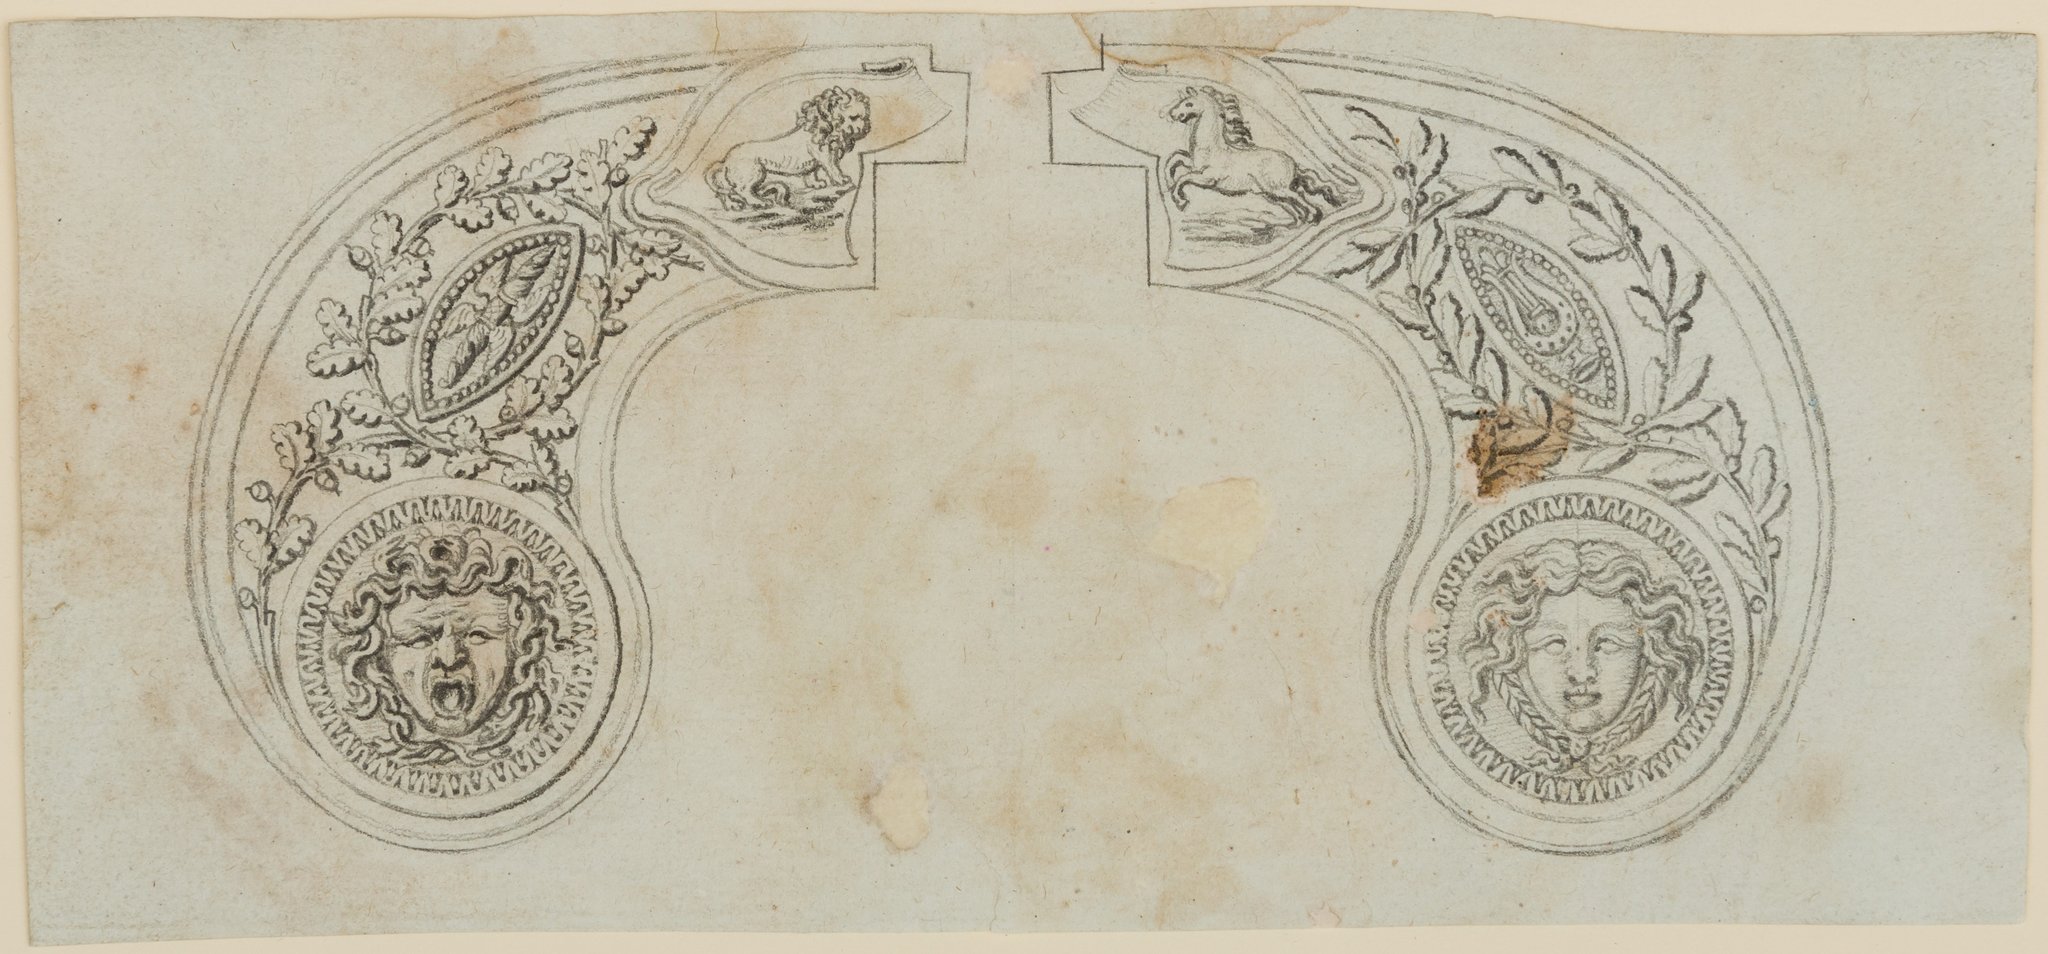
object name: drawing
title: Pair of Designs for the Decoration of the Grips of Pocket Pistols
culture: french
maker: nicolas noël boutet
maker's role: designer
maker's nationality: french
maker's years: 1761-1833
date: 1797-1805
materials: ink, paper, pencil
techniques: wash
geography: france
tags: faces,horses,lions